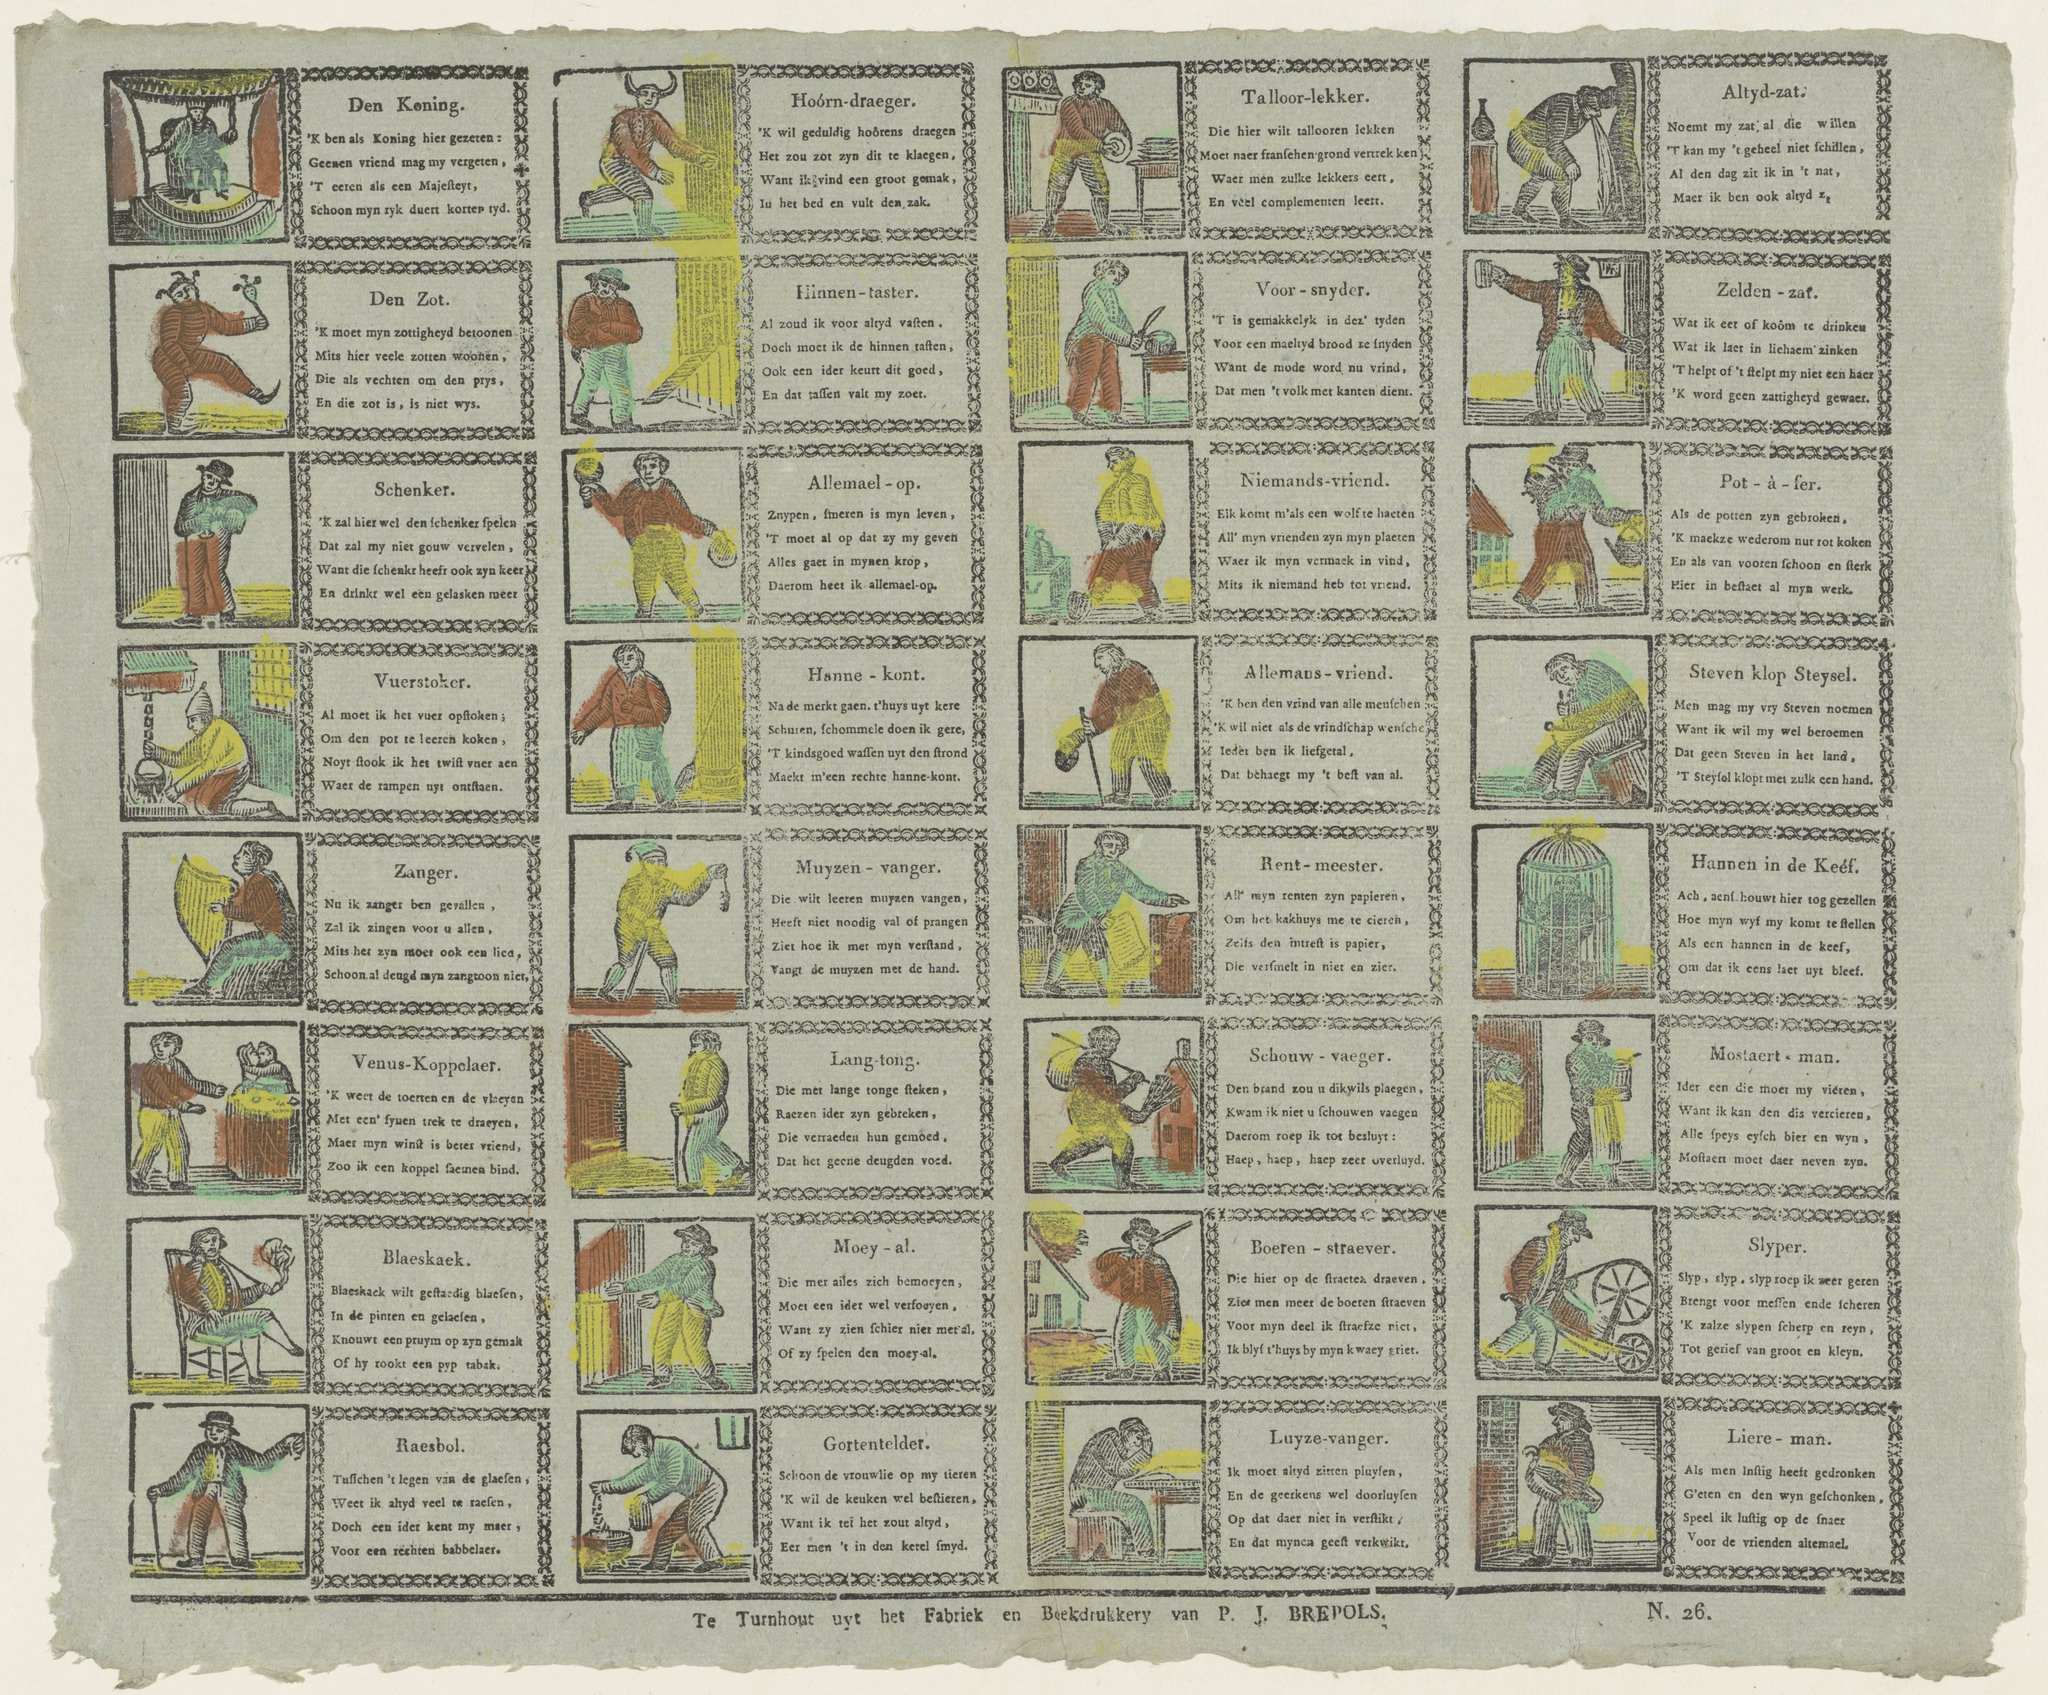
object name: print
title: Driekoningenbriefjes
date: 1800-1833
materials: paper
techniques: colour, letterpress printing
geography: turnhout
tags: twelfth night, usually falling on the eve of january 6, royal household; courtiers, retinue, train, epiphany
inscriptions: collector's mark: Lugt 2760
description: Blad met 32 voorstellingen (driekoningenbriefjes) van verschillende functies binnen het hof, waaronder de koning, de zot, de vuurstoker en de zanger. Rechts naast elke afbeelding een vierregelig vers. Genummerd rechtsonder: N. 26.